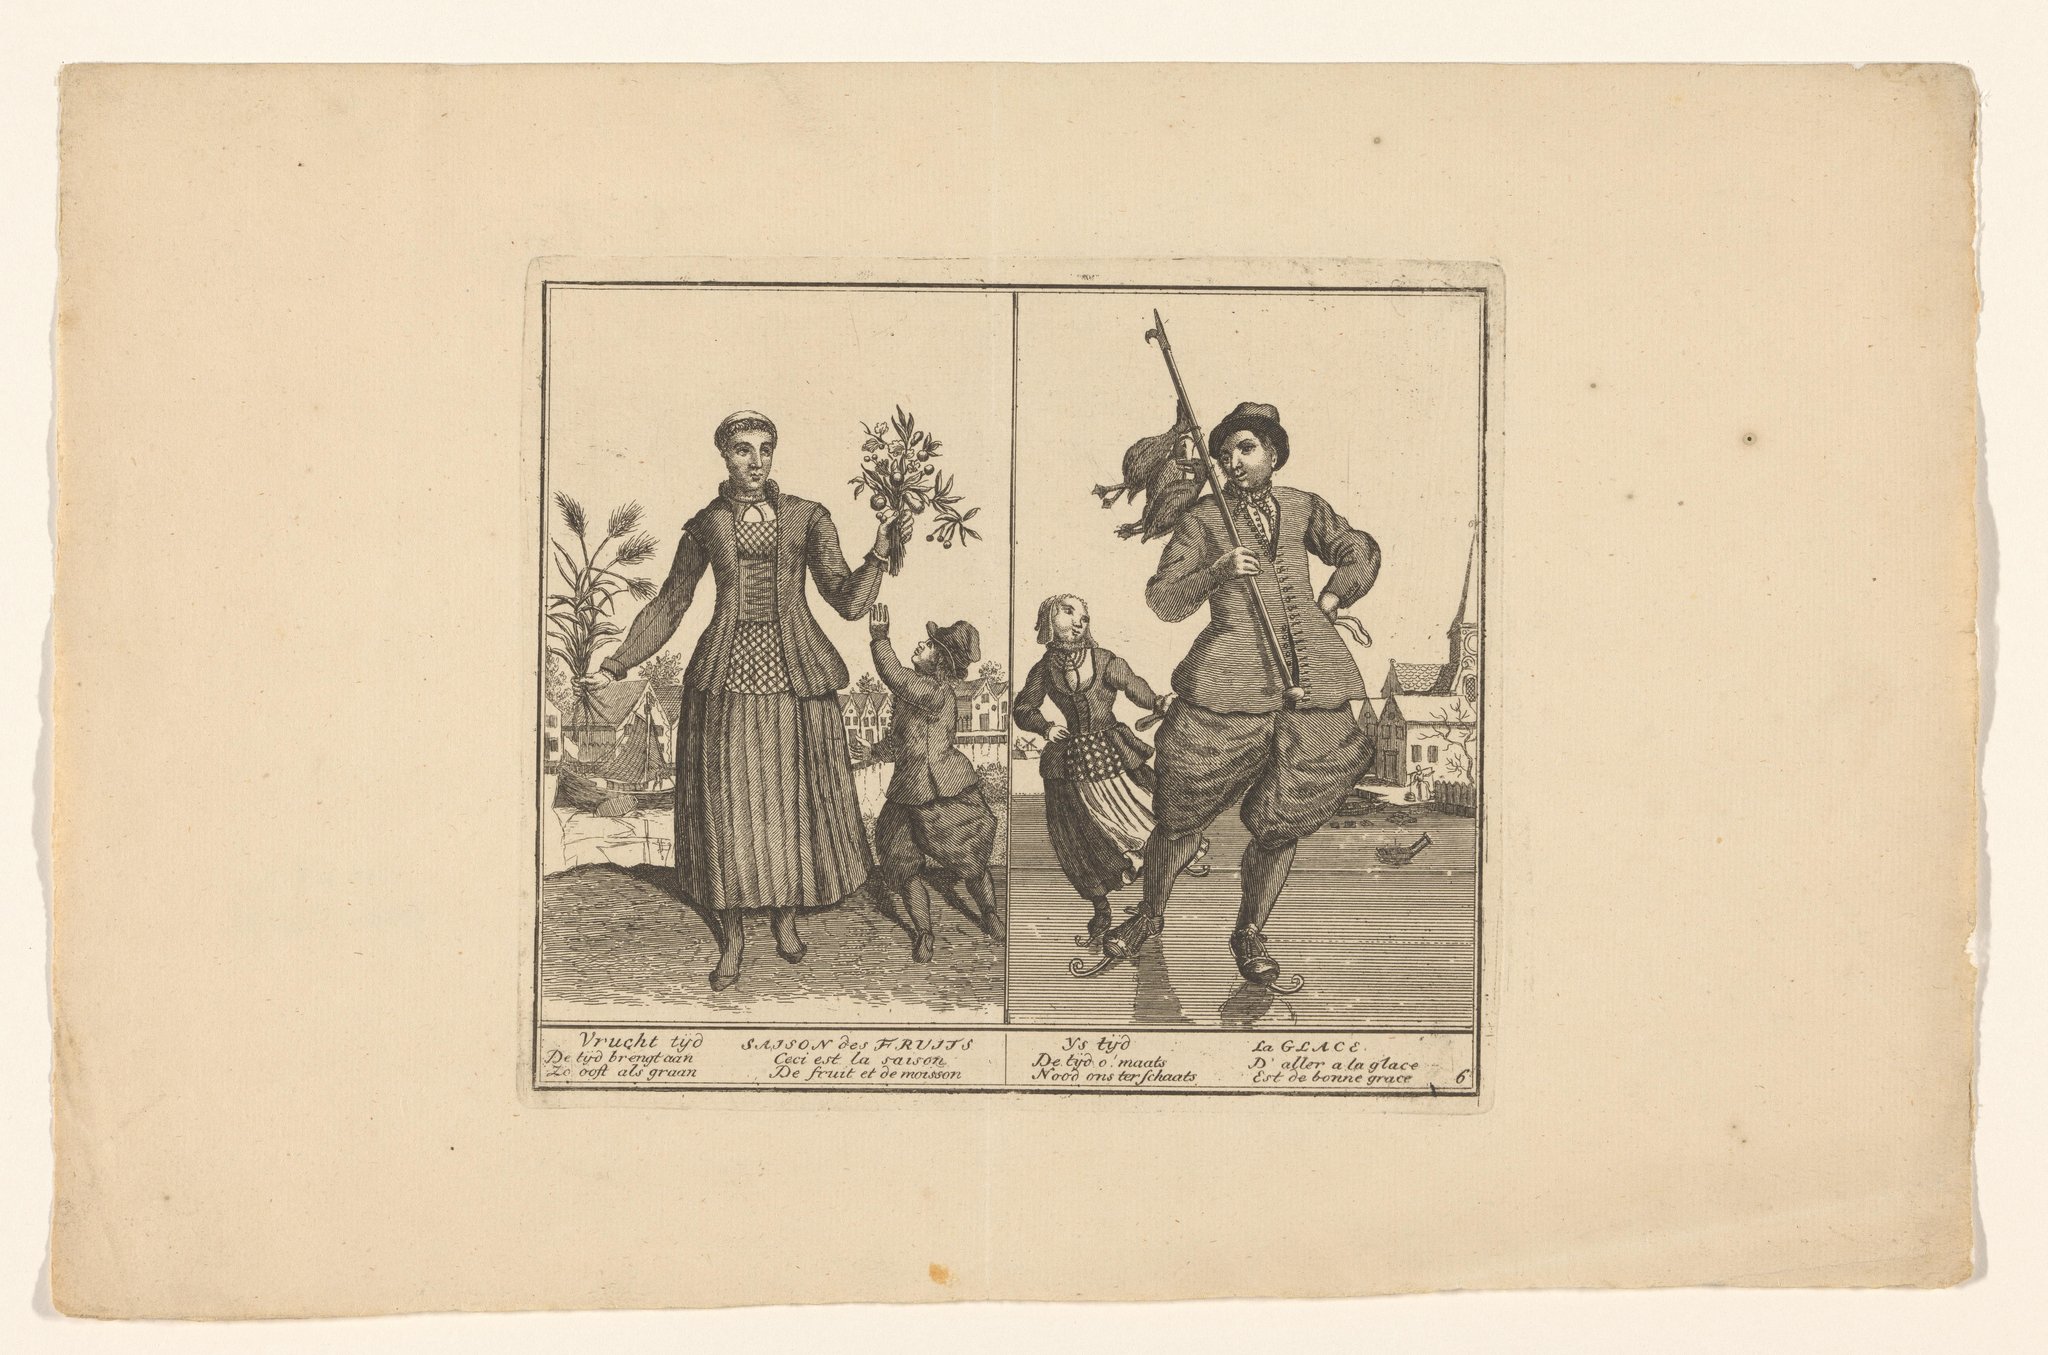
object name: print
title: Hollandse Dorpelingen enz. Tweede Deel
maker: abraham allard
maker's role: print maker, publisher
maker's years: 1676-1725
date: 1676-1725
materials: paper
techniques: etching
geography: amsterdam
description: Links een vrouw en kind met takken met vruchten en graan. Rechts een man een meisje op schaatsen met dode eenden aan een stok.